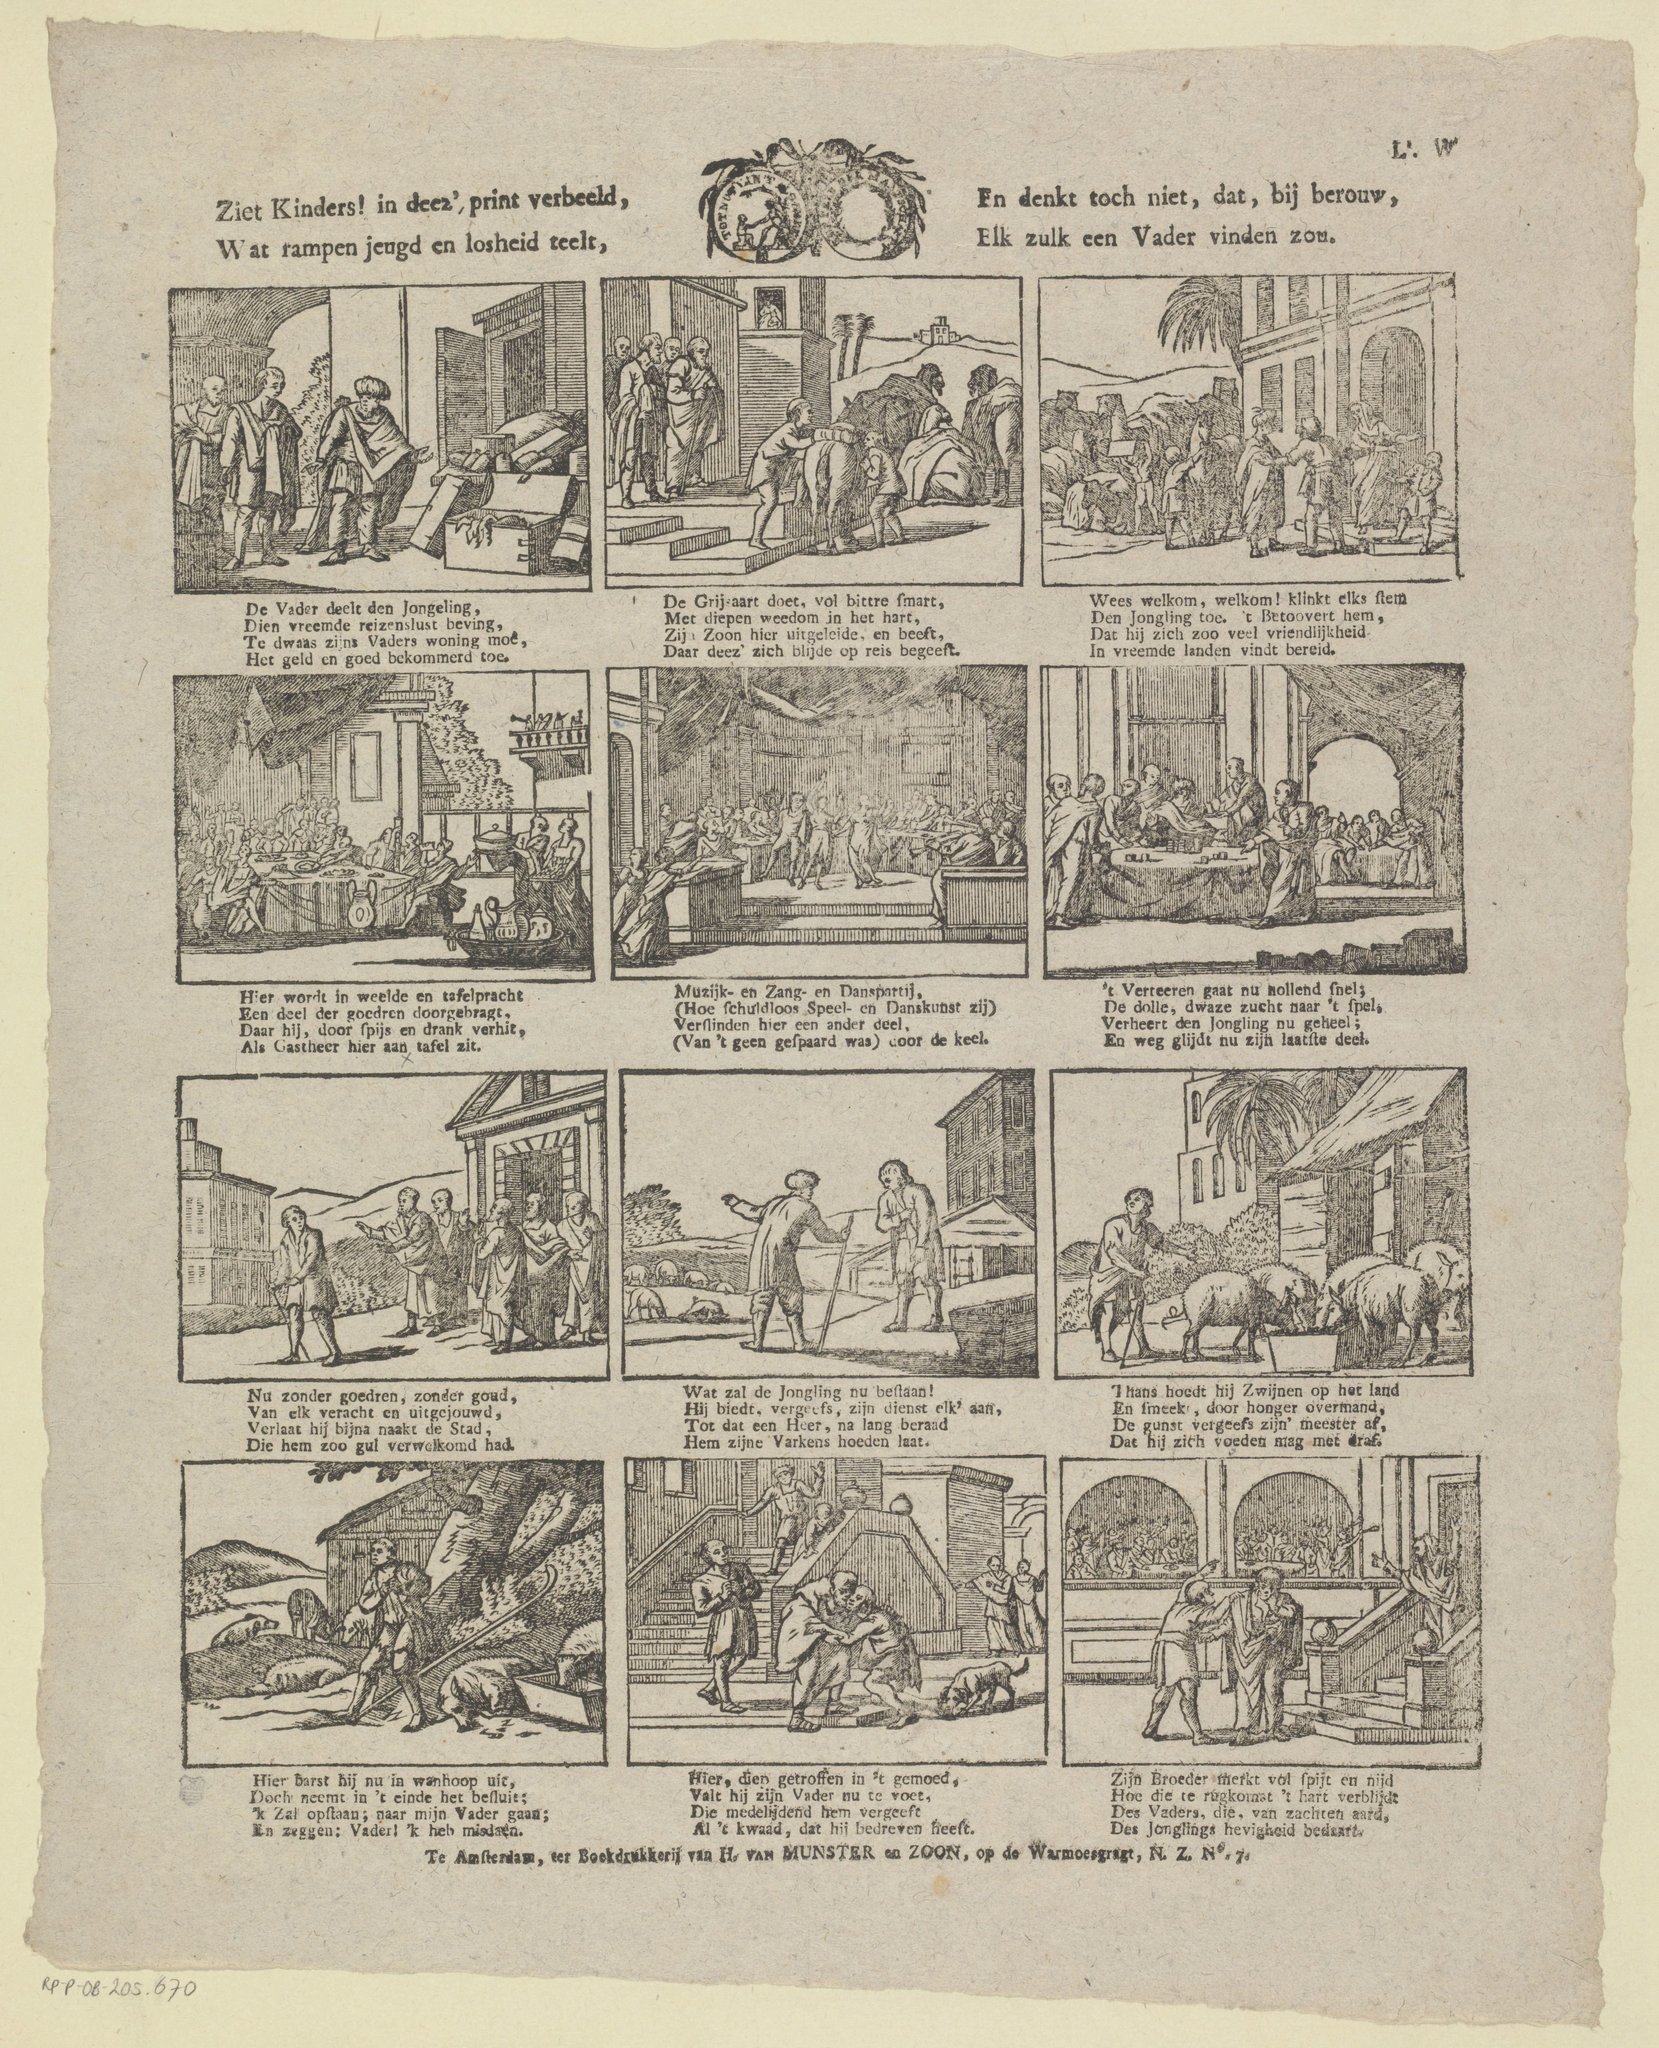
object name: print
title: Ziet kinders! in deez' print verbeeld, / Wat rampen jeugd en losheid teelt, / En denkt toch niet, dat, bij berouw, / Elk zulk een vader vinden zou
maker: Anonymous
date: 1811-1829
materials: paper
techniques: letterpress printing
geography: netherlands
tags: the parable of the prodigal son (luke 15:11-32)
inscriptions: collector's mark: Lugt 2760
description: Blad met 12 voorstellingen van het verhaal van de Verloren Zoon. Midden boven het zegel van de Maatschappij tot Nut van 't Algemeen. Onder elke afbeelding een vierregelig vers. Genummerd rechtsboven: L.W.